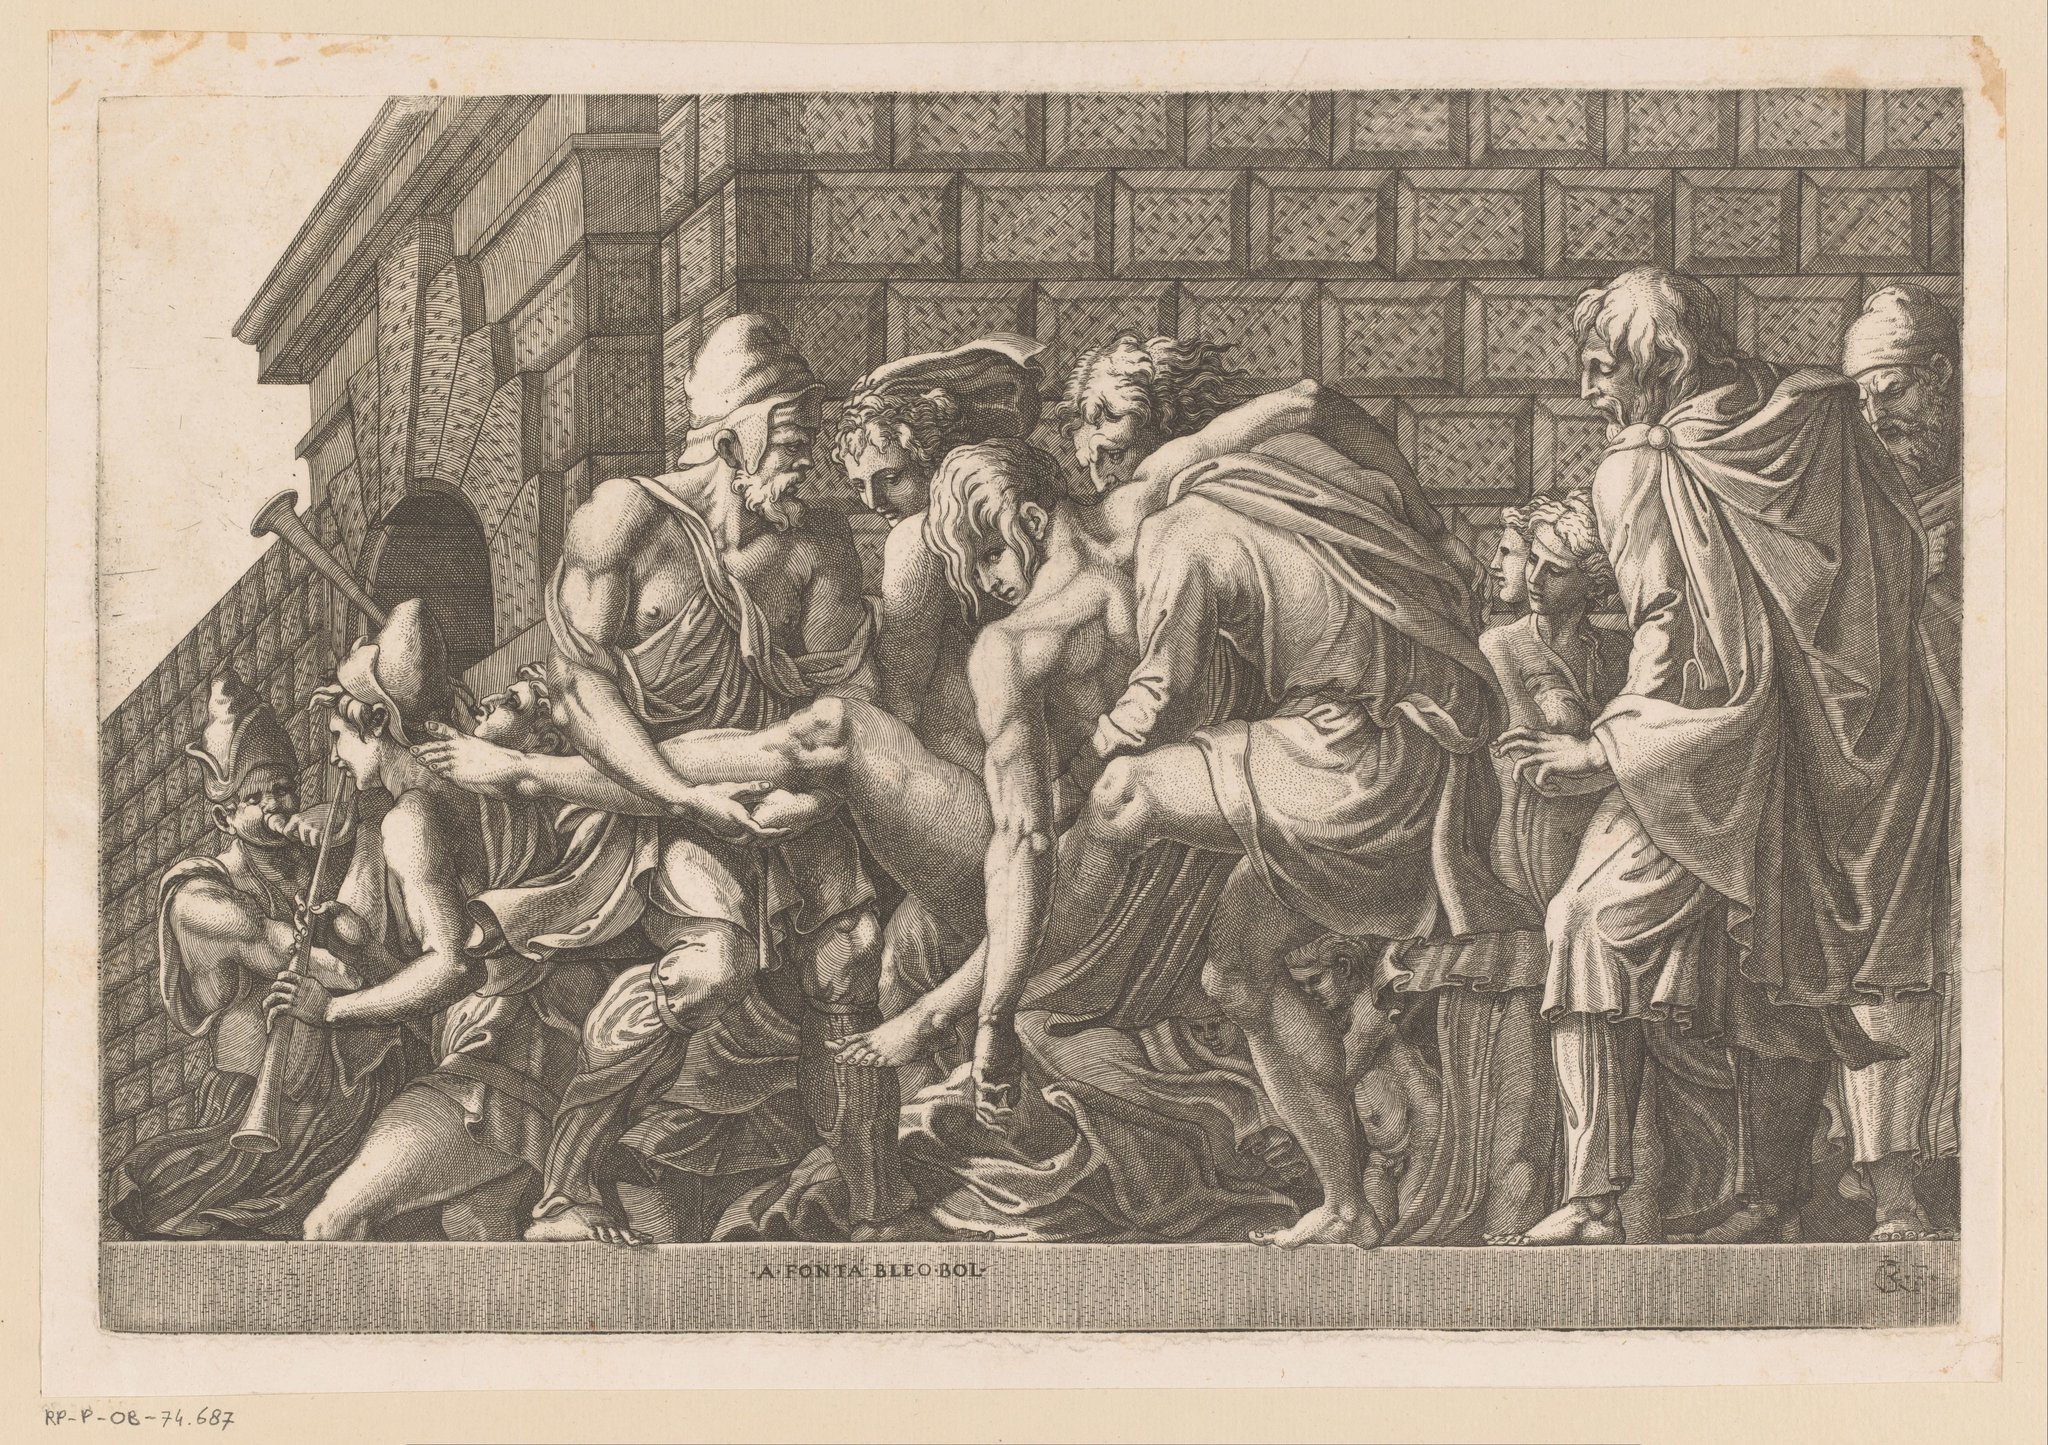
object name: print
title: Geblesseerde Hector wordt terug gedragen langs de muren van Troje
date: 1532-1572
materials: paper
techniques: engraving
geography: fontainebleau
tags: hector - suffering, misfortune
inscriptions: collector's mark: Lugt 240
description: Betreft een prent naar een fresco door Primaticcio voor de vestibule van de Porte Dorée te Fontainebleau. De voorbereidende tekening door Primaticcio bevindt zich in de collectie van het Musée du Louvre te Parijs, inv.nr. 8567.